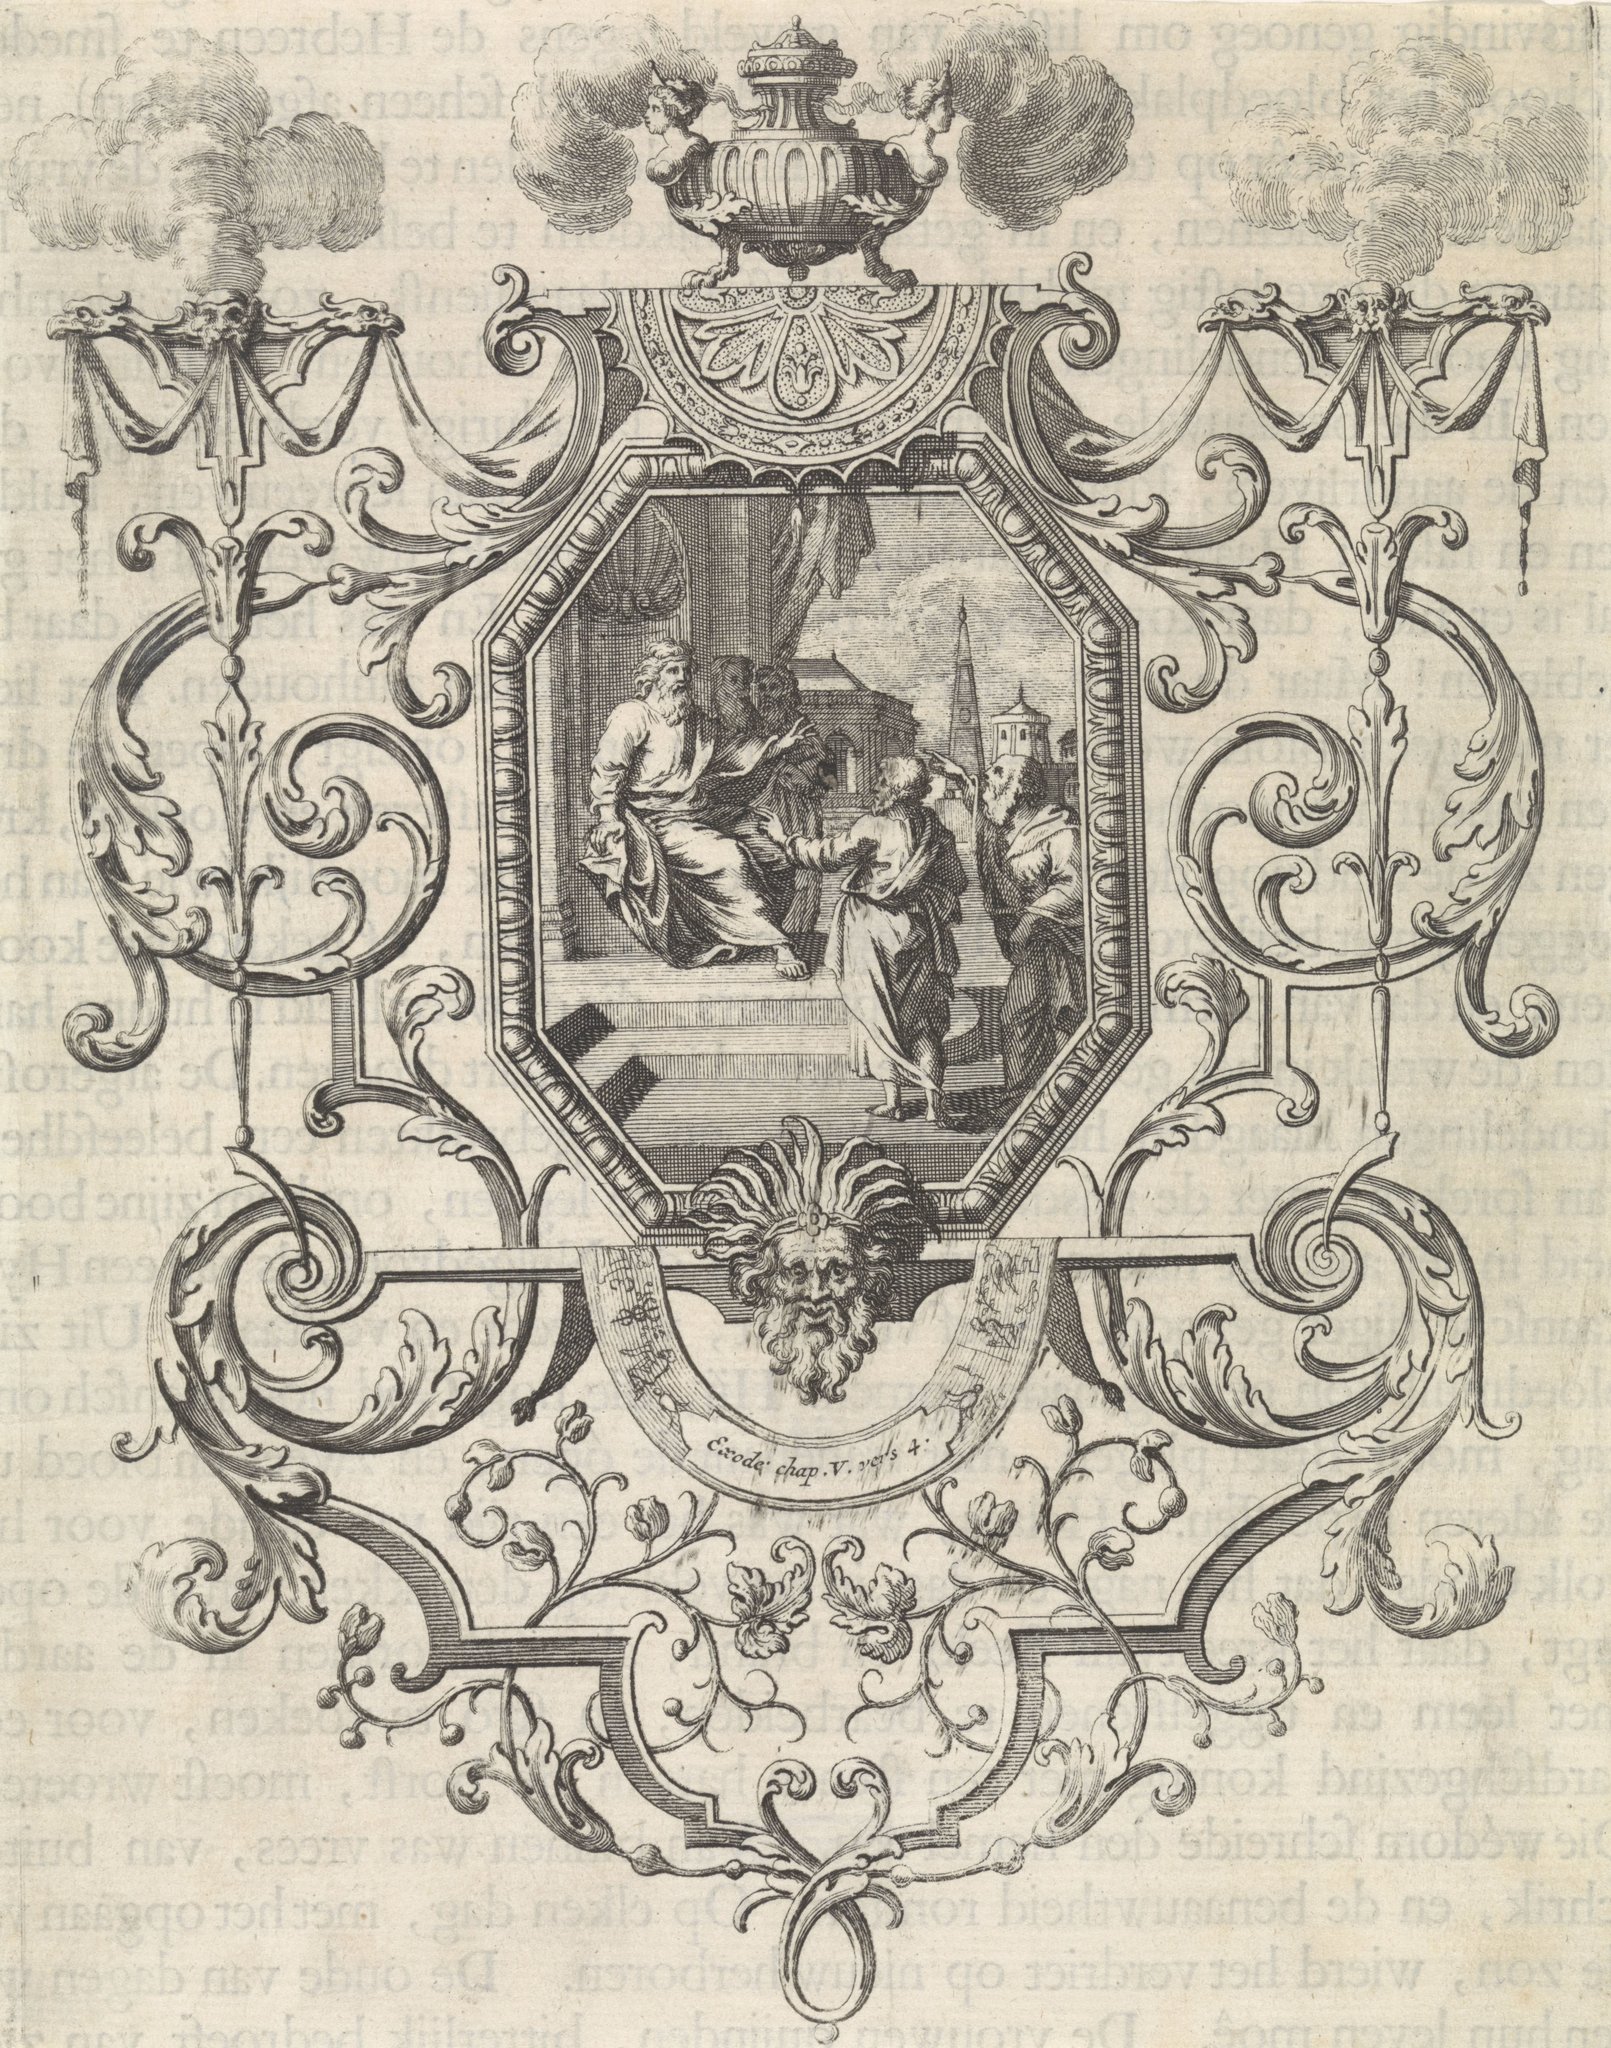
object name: book illustration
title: Zittende putto met een lauwerkrans in de handen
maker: bernard picart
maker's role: draughtsman, print maker, publisher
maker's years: 1673-1733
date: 1683-1733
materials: paper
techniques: engraving, etching, letterpress printing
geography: amsterdam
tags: moses and aaron confront pharaoh (exodus 5-7:13), foliage, tendrils, branches ~ ornament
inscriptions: collector's mark: Lugt 2228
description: Prent oorspronkelijk bedoeld voor: Figures de la Bible. Amsterdam, Bernard Picart, 1720. Prent ook gebruikt in: Taferelen der voornaamste geschiedenissen van het Oude en Nieuwe Testament (...) door de vermaarde kunstenaars Hoet, Houbraken, en Picart getekent (...) en met beschrijvingen uitgebreid. Den Haag: Pieter de Hondt, 1728. Prent kan mogelijk ook zijn gebruikt in andere bijbels.